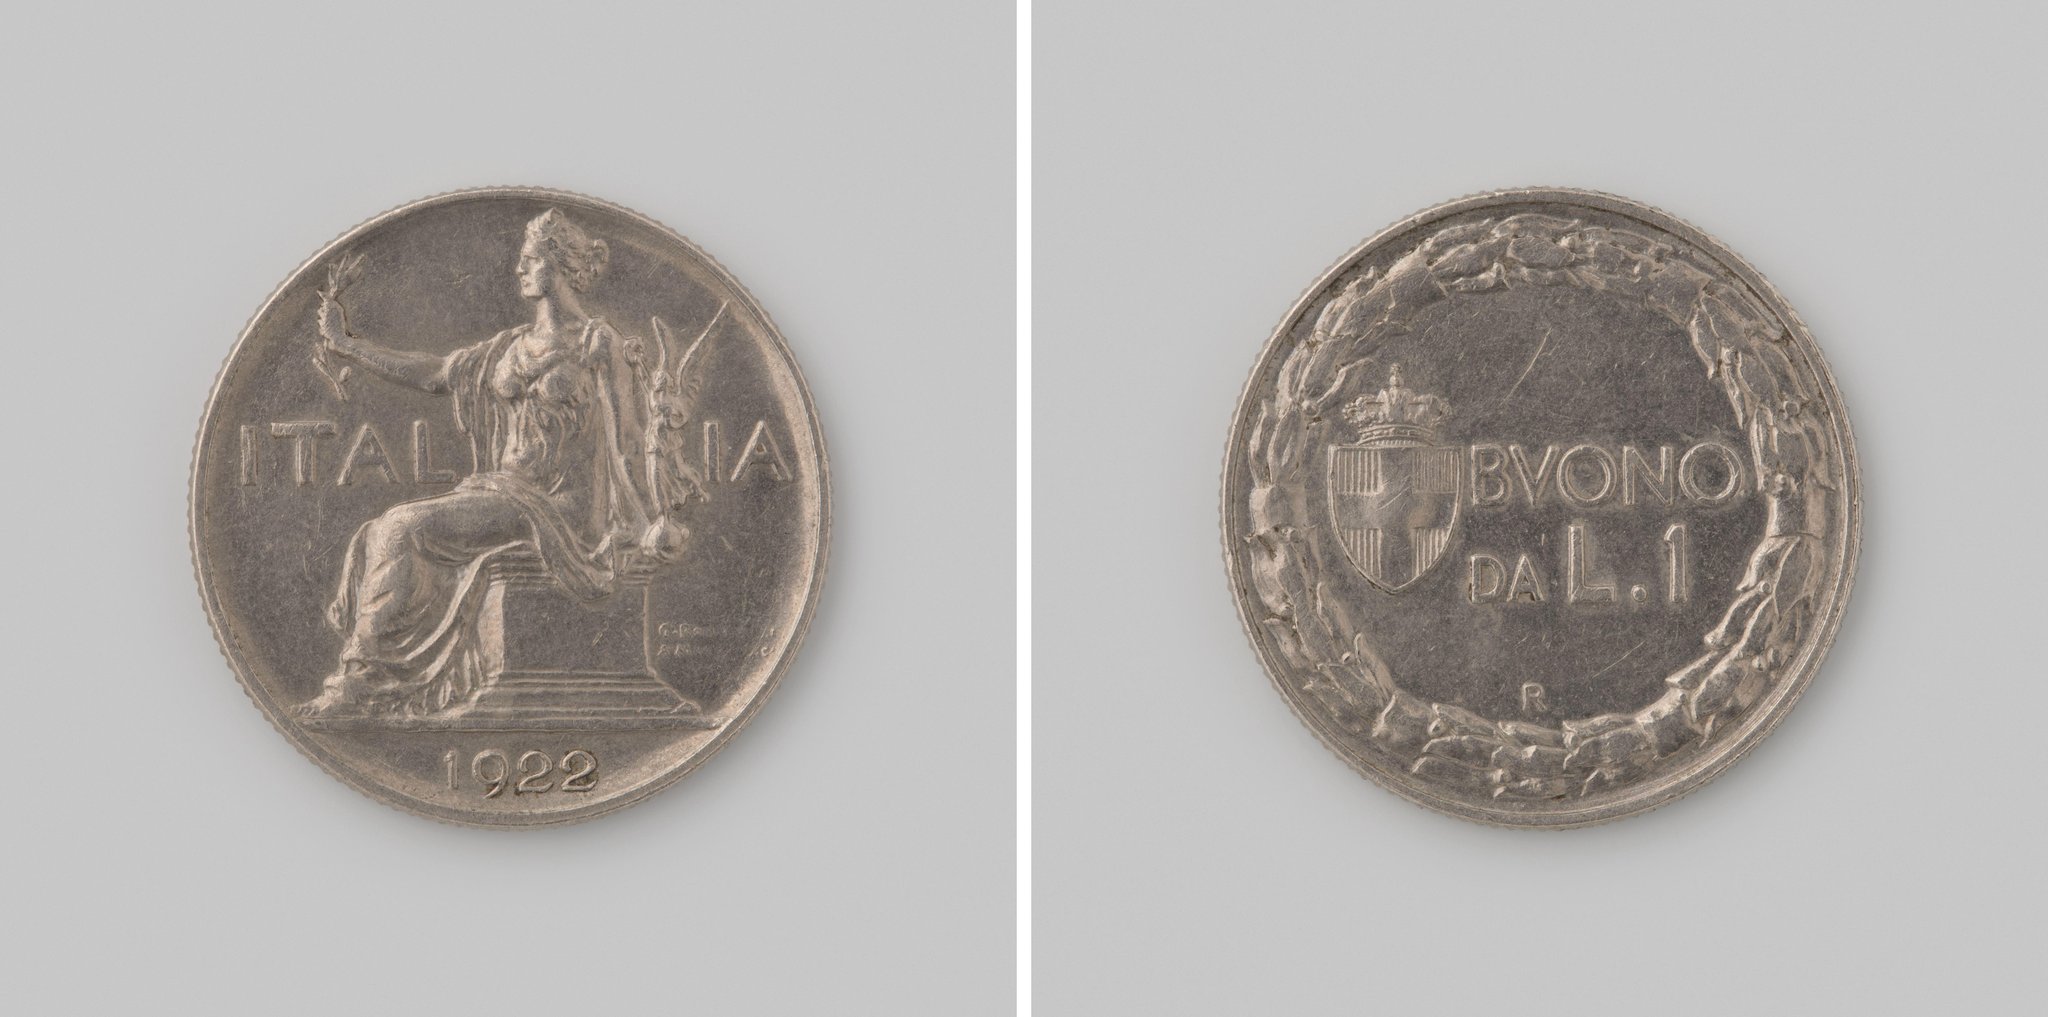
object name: coin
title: Italië, koning Vittorio Emanuele III, lira, 1922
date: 1922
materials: nickel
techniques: striking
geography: rome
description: Nikkelen munt. Voorzijde: vrouw, gezeten op sokkel, naar links kijkend met in beide handen symbolen. In afsnede jaartal. Keerzijde: binnen krans gekroond wapenschild van Italië met rechts daarvan in twee regels waarde-aanduiding: bvono da L.1. Onderaan muntteken: letter R [=Rome]. Kartelrand.